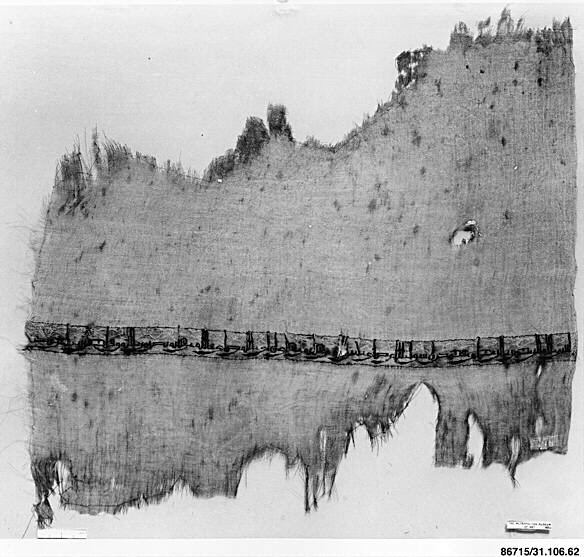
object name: textile fragment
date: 1035-1094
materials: linen, silk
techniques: weave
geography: egypt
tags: arabic